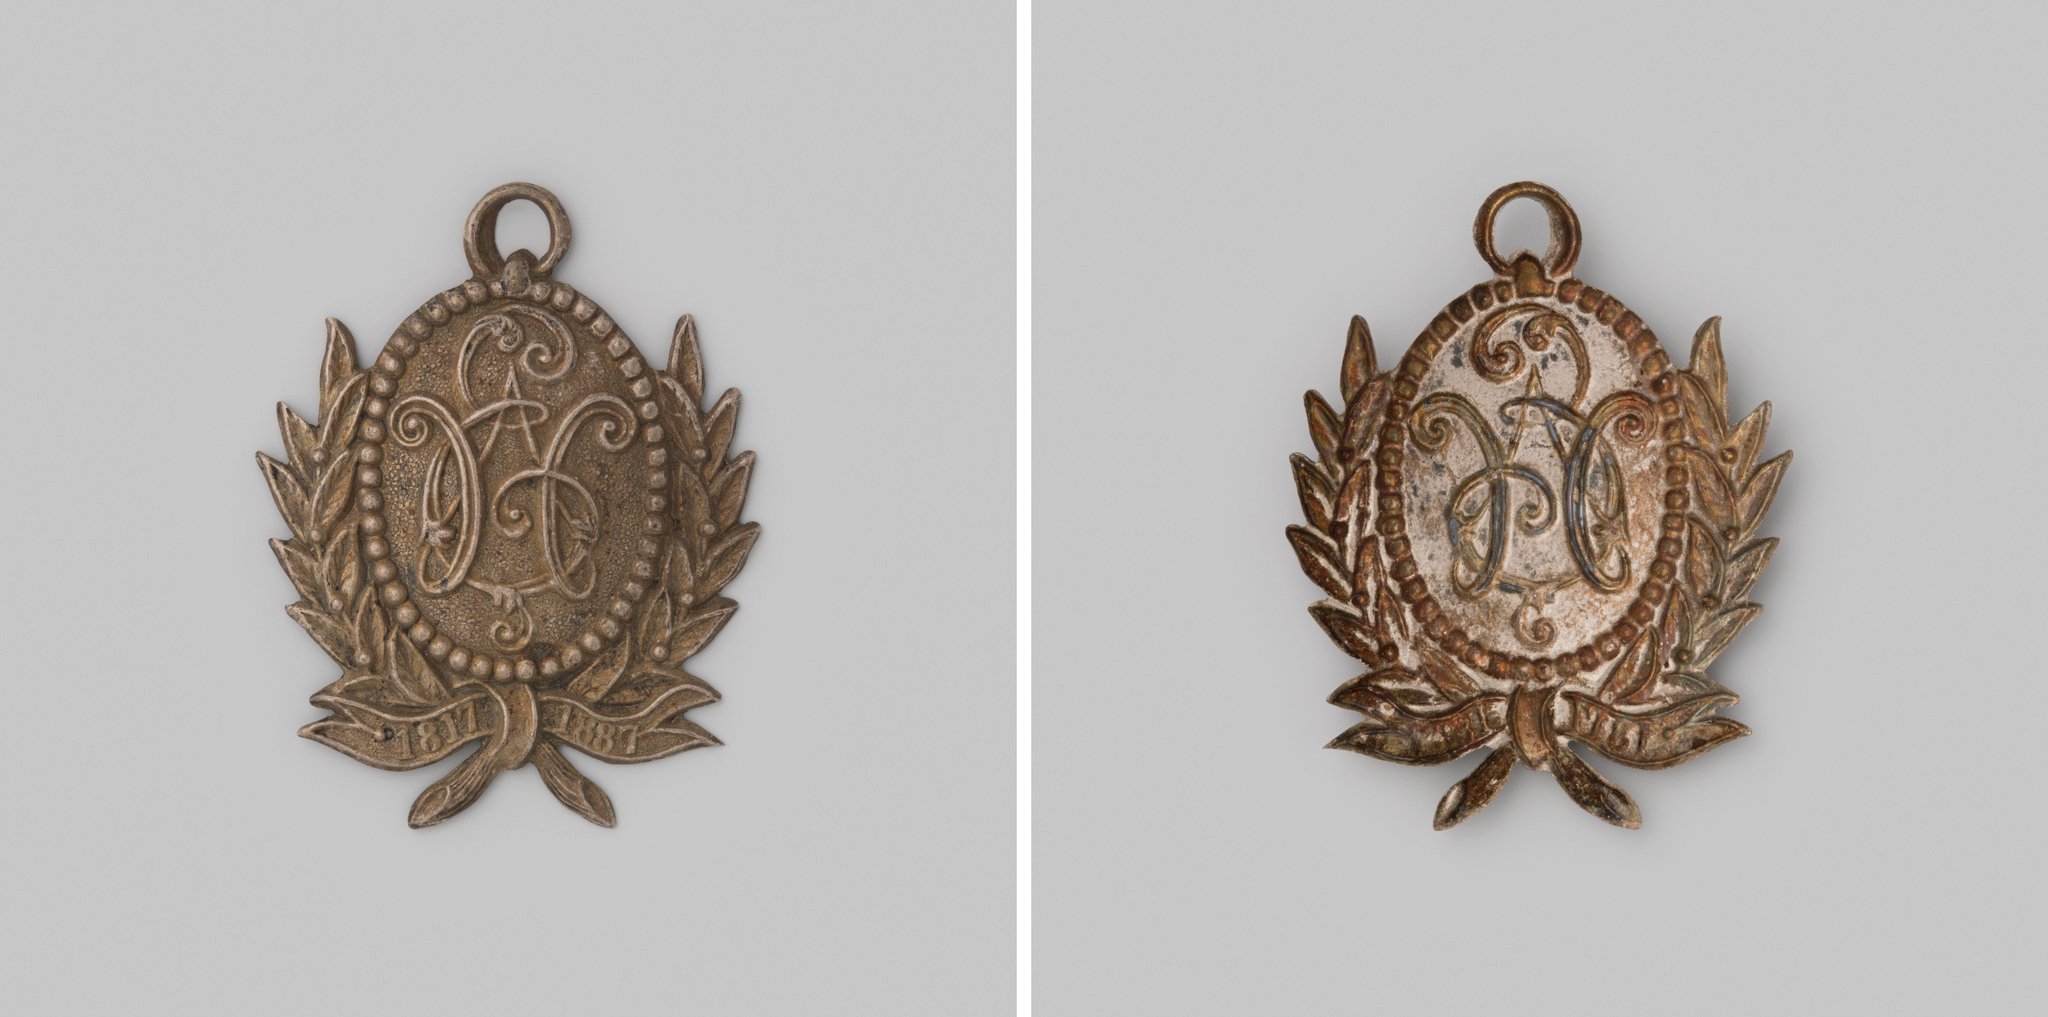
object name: history medal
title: Zeventigste verjaardag van Koning Willem III 1887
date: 1887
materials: silver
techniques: pressing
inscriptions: inscription: ‘1817 - 1887’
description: Eenzijdig zilveren draagteken met oog, WE-monogram op een ovaal veld met parelrand, tussen lauwertakken samengebonden met een tekstlint.